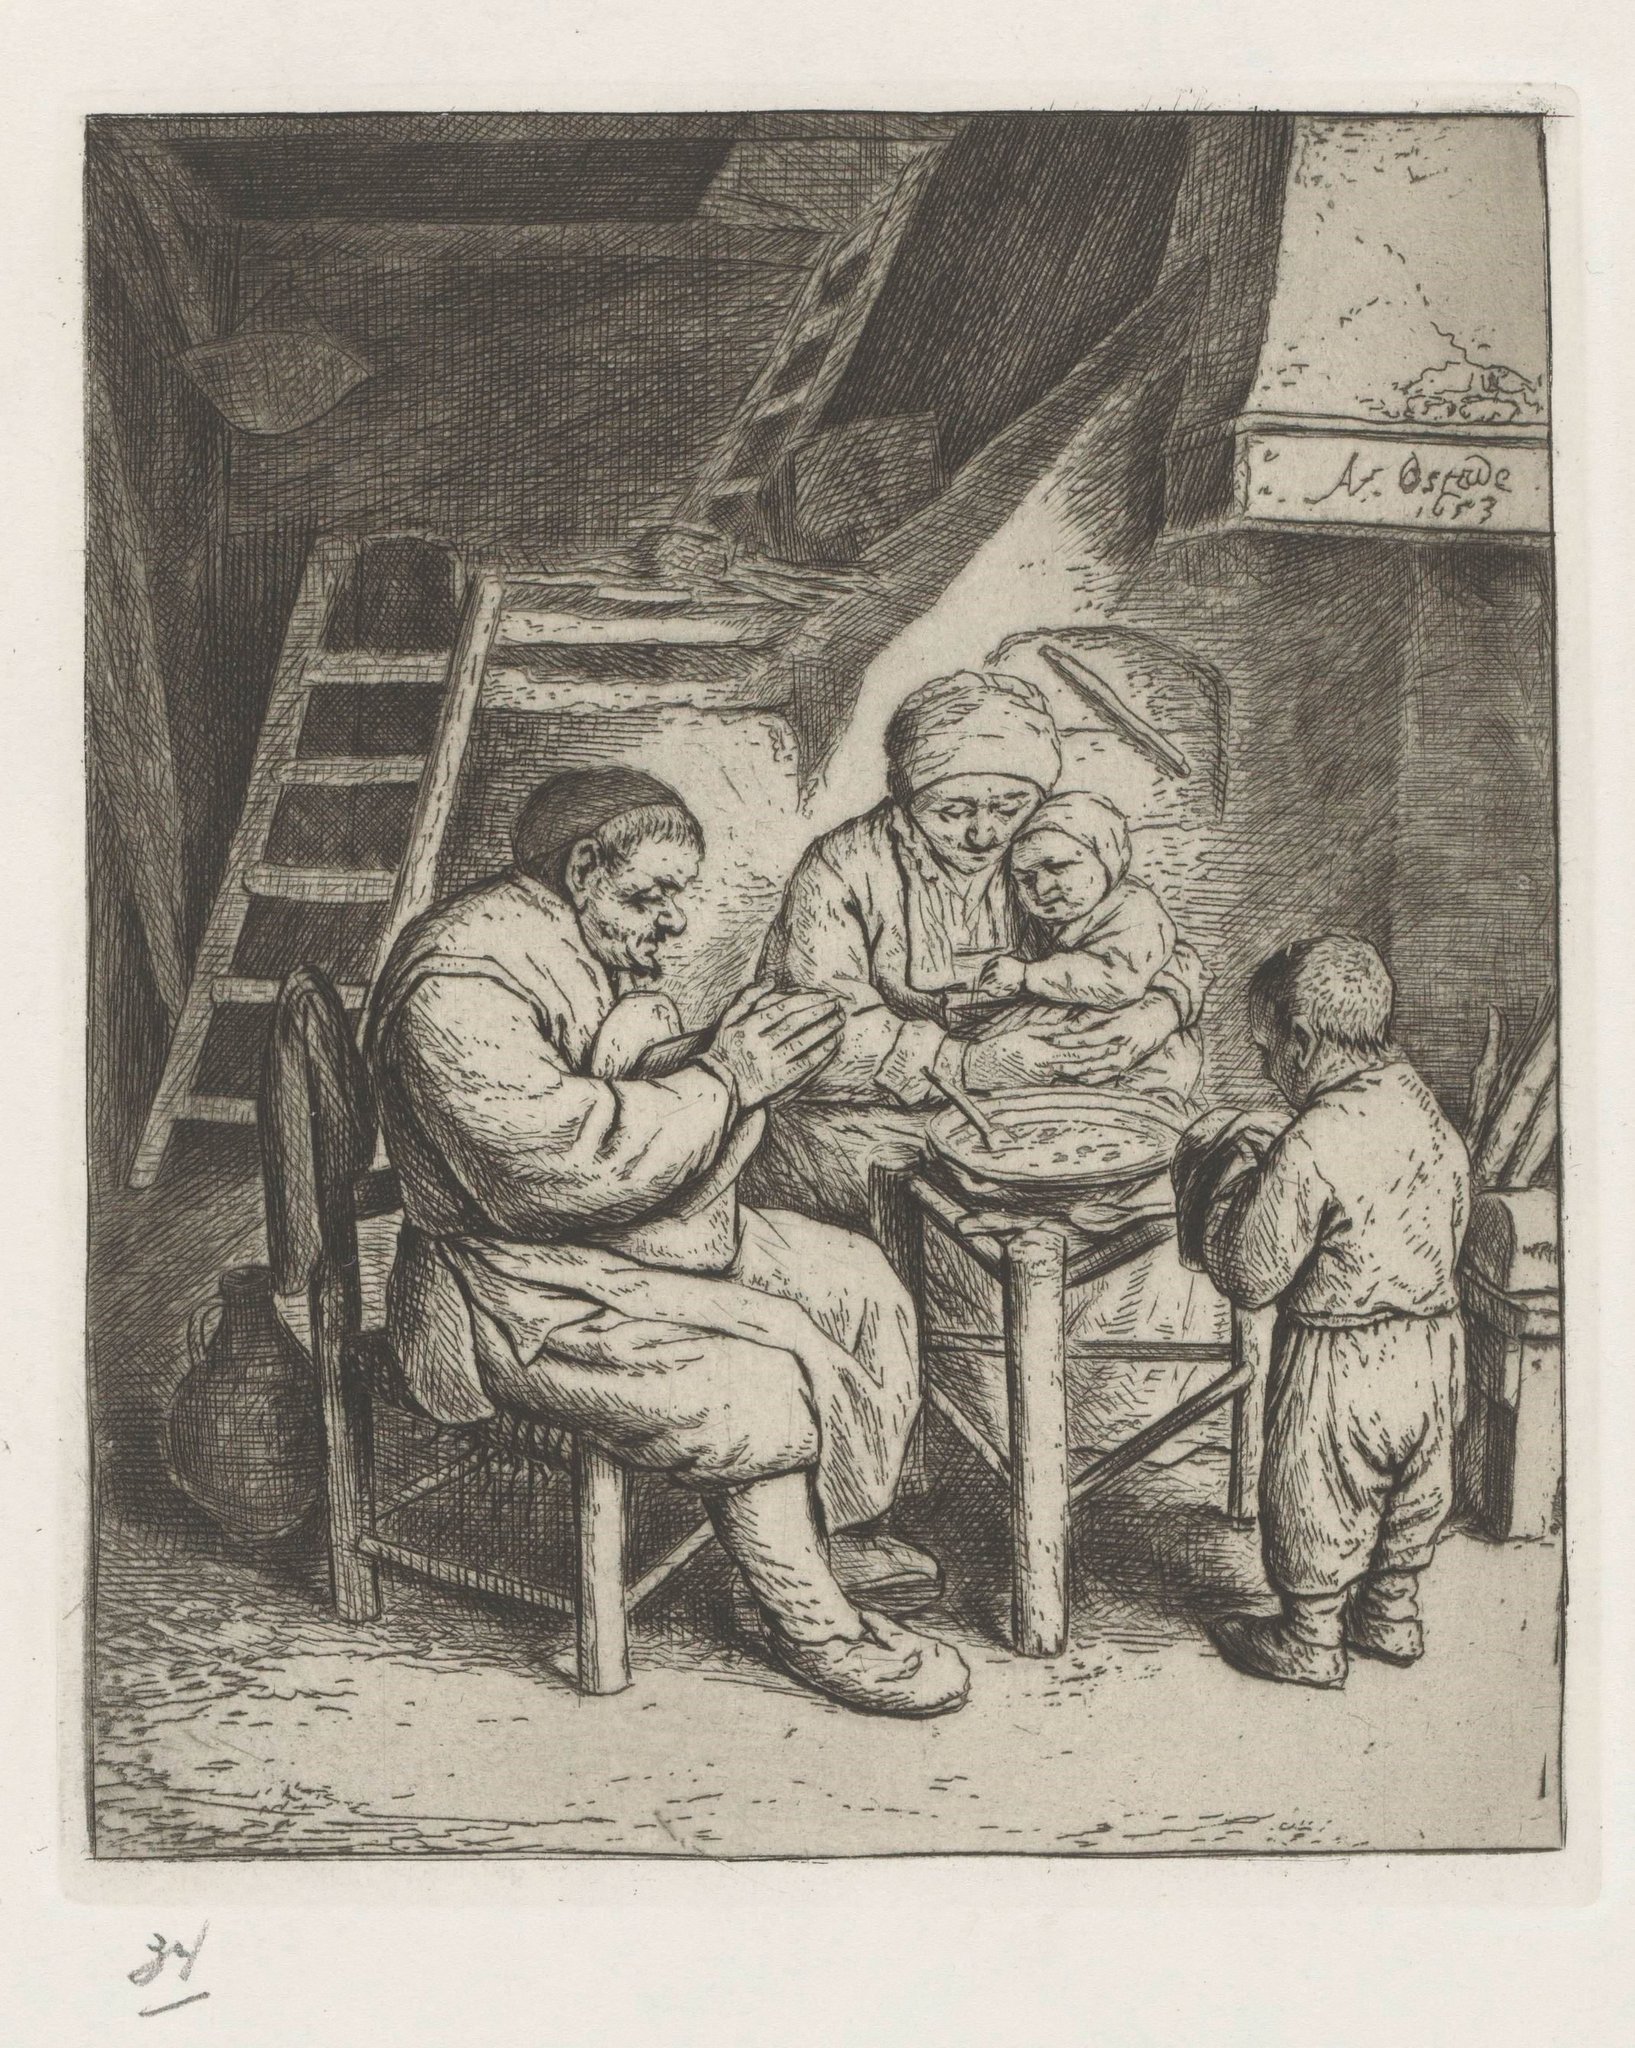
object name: album leaf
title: Gezin aan tafel voor de maaltijd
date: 1653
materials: paper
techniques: etching, galvanization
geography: haarlem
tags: family life, prayer at table, saying grace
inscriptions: collector's mark: ‘B’, collector's mark: ‘RIJKS / MUSM’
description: Een vader en moeder met twee kinderen zitten bij een kleine tafel met hun handen gevouwen voor het gebed. Op de tafel staat een grote pan met eten. Het gezin zit vlakbij een haard in een sober ingericht vertrek. De prent maakt deel uit van een portefeuille.